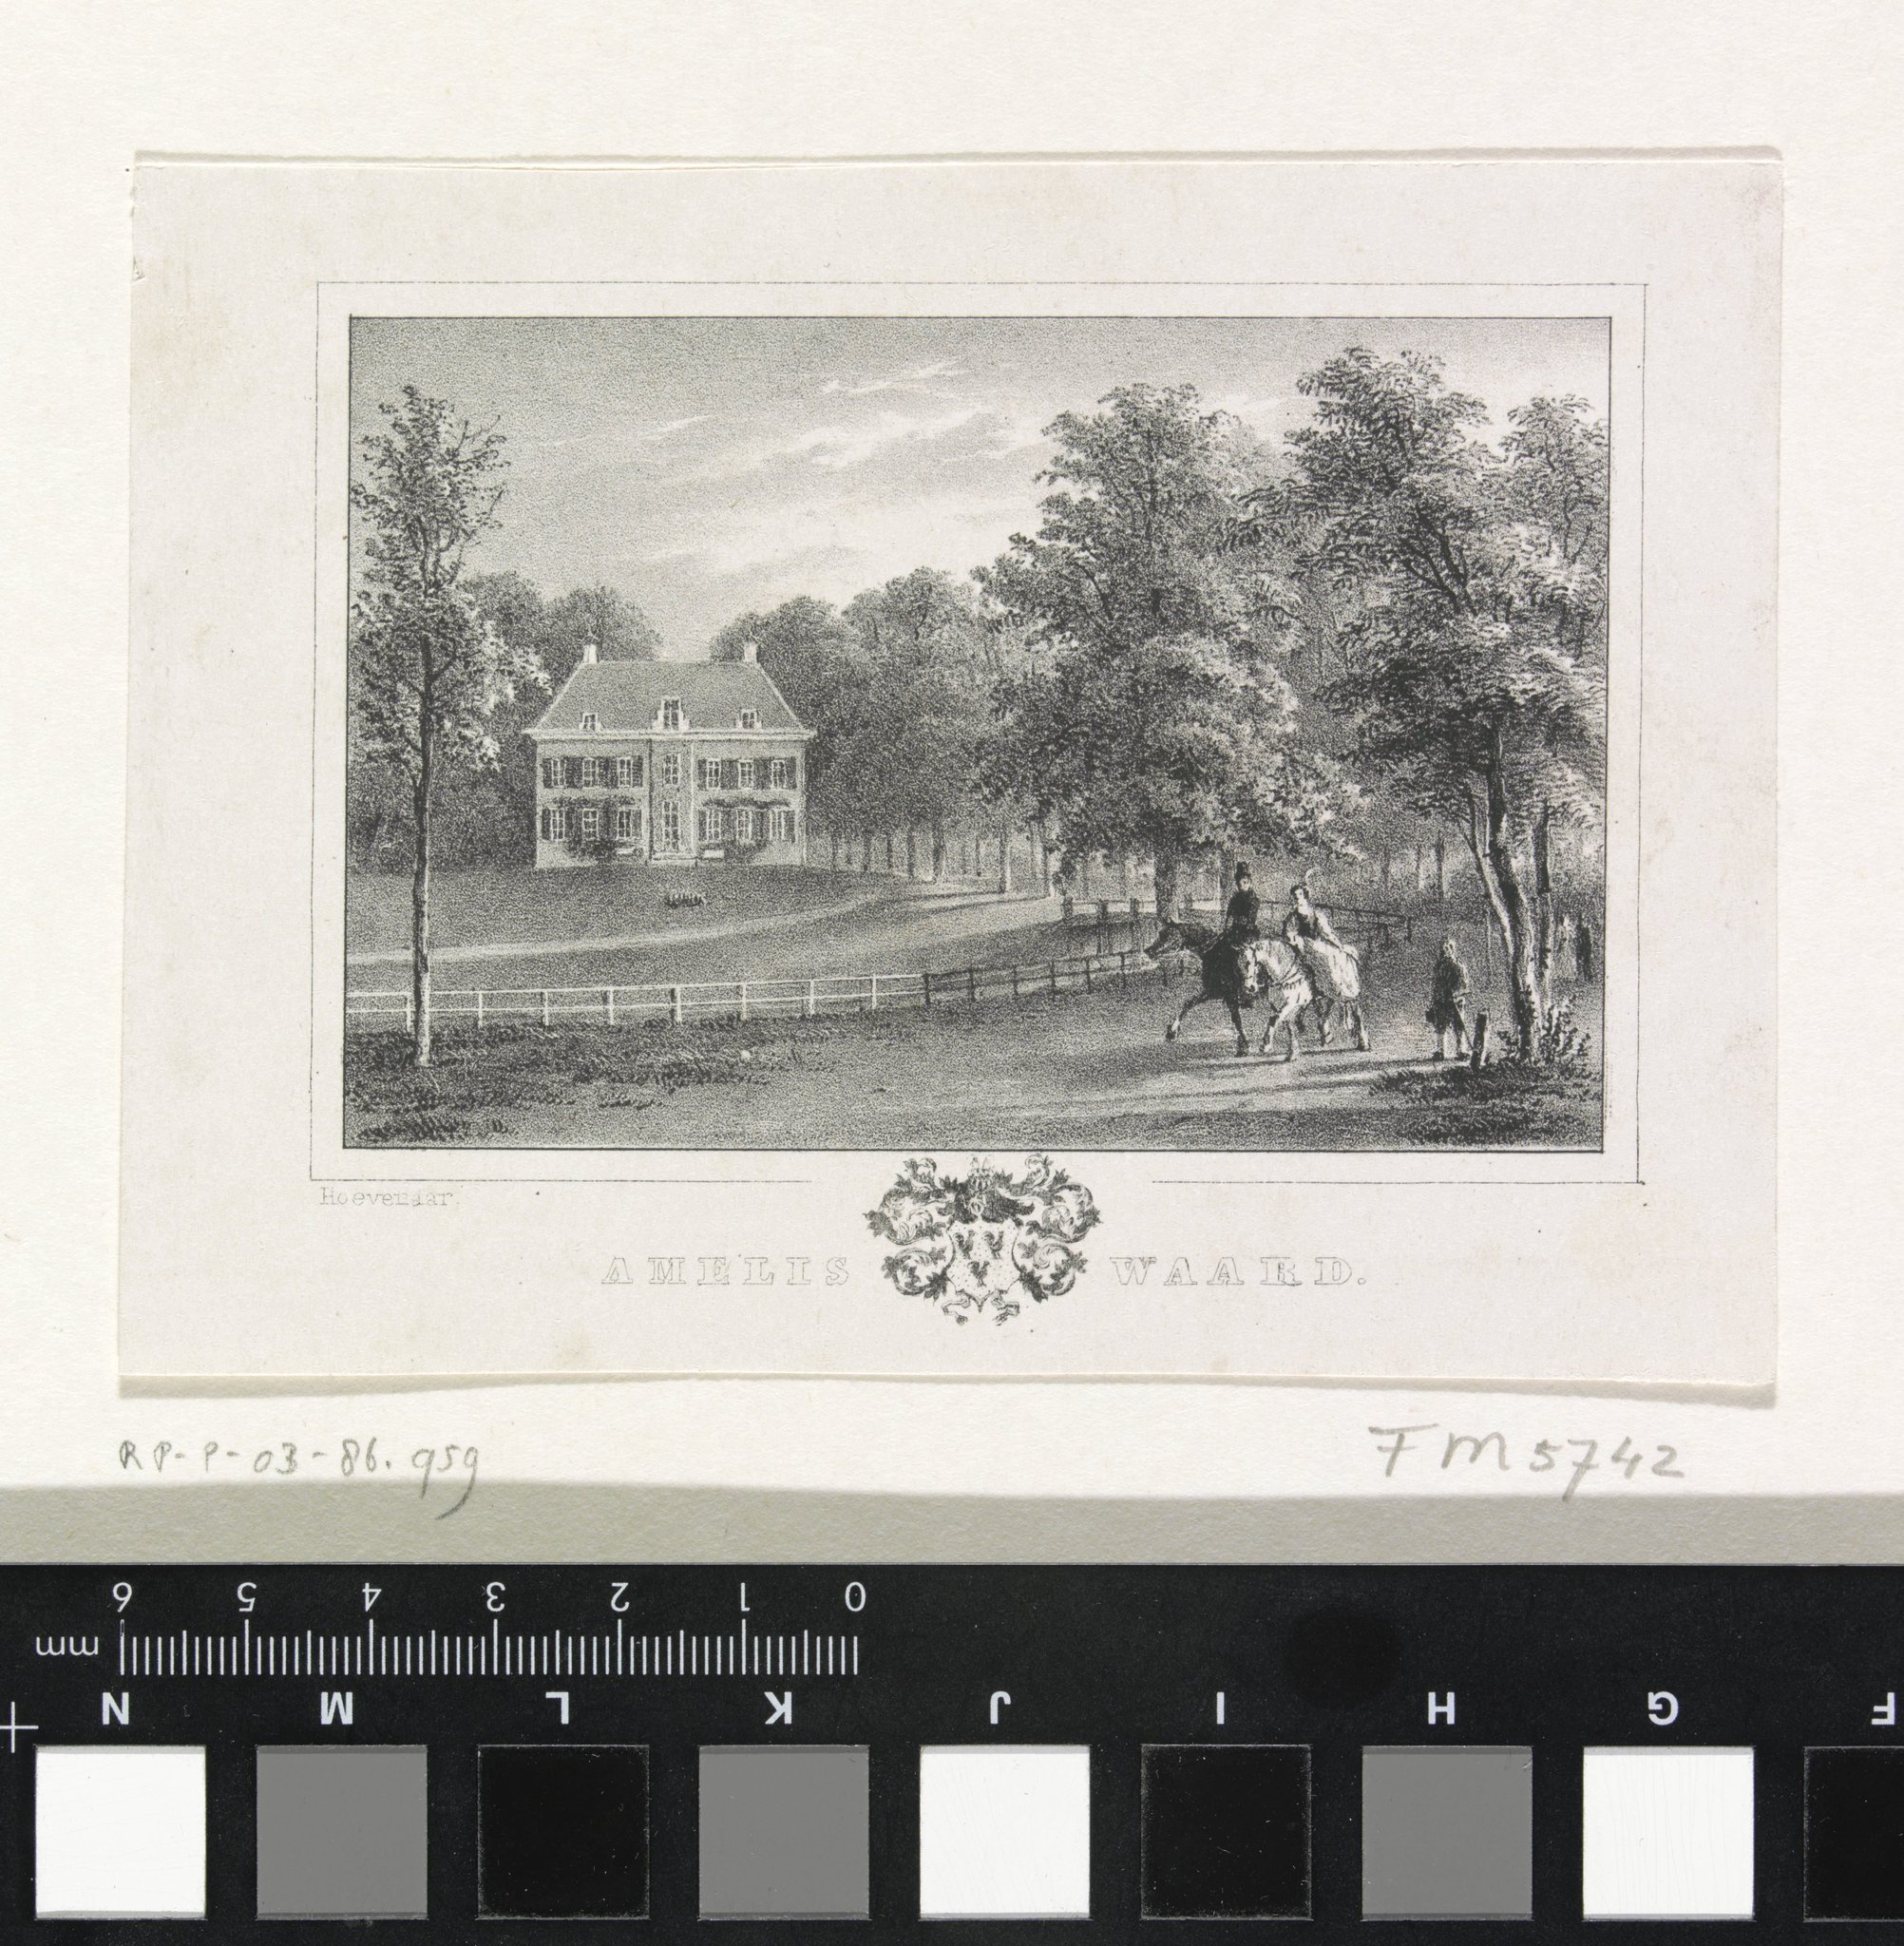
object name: pamphlet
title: Ameliswaard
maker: willem pieter hoevenaar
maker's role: draughtsman, painter, print maker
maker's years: 1808-1863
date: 1840-1841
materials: paper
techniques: lithograph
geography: netherlands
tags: louis napoleon (king of holland), castle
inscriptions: collector's mark: Lugt 2228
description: Gezicht op kasteel Oud-Ameliswaard, op de voorgrond enkele ruiters, in de marge een wapen. Koning Lodewijk Napoleon was in 1807 (of 1808) voor korte tijd eigenaar van dit landhuis.